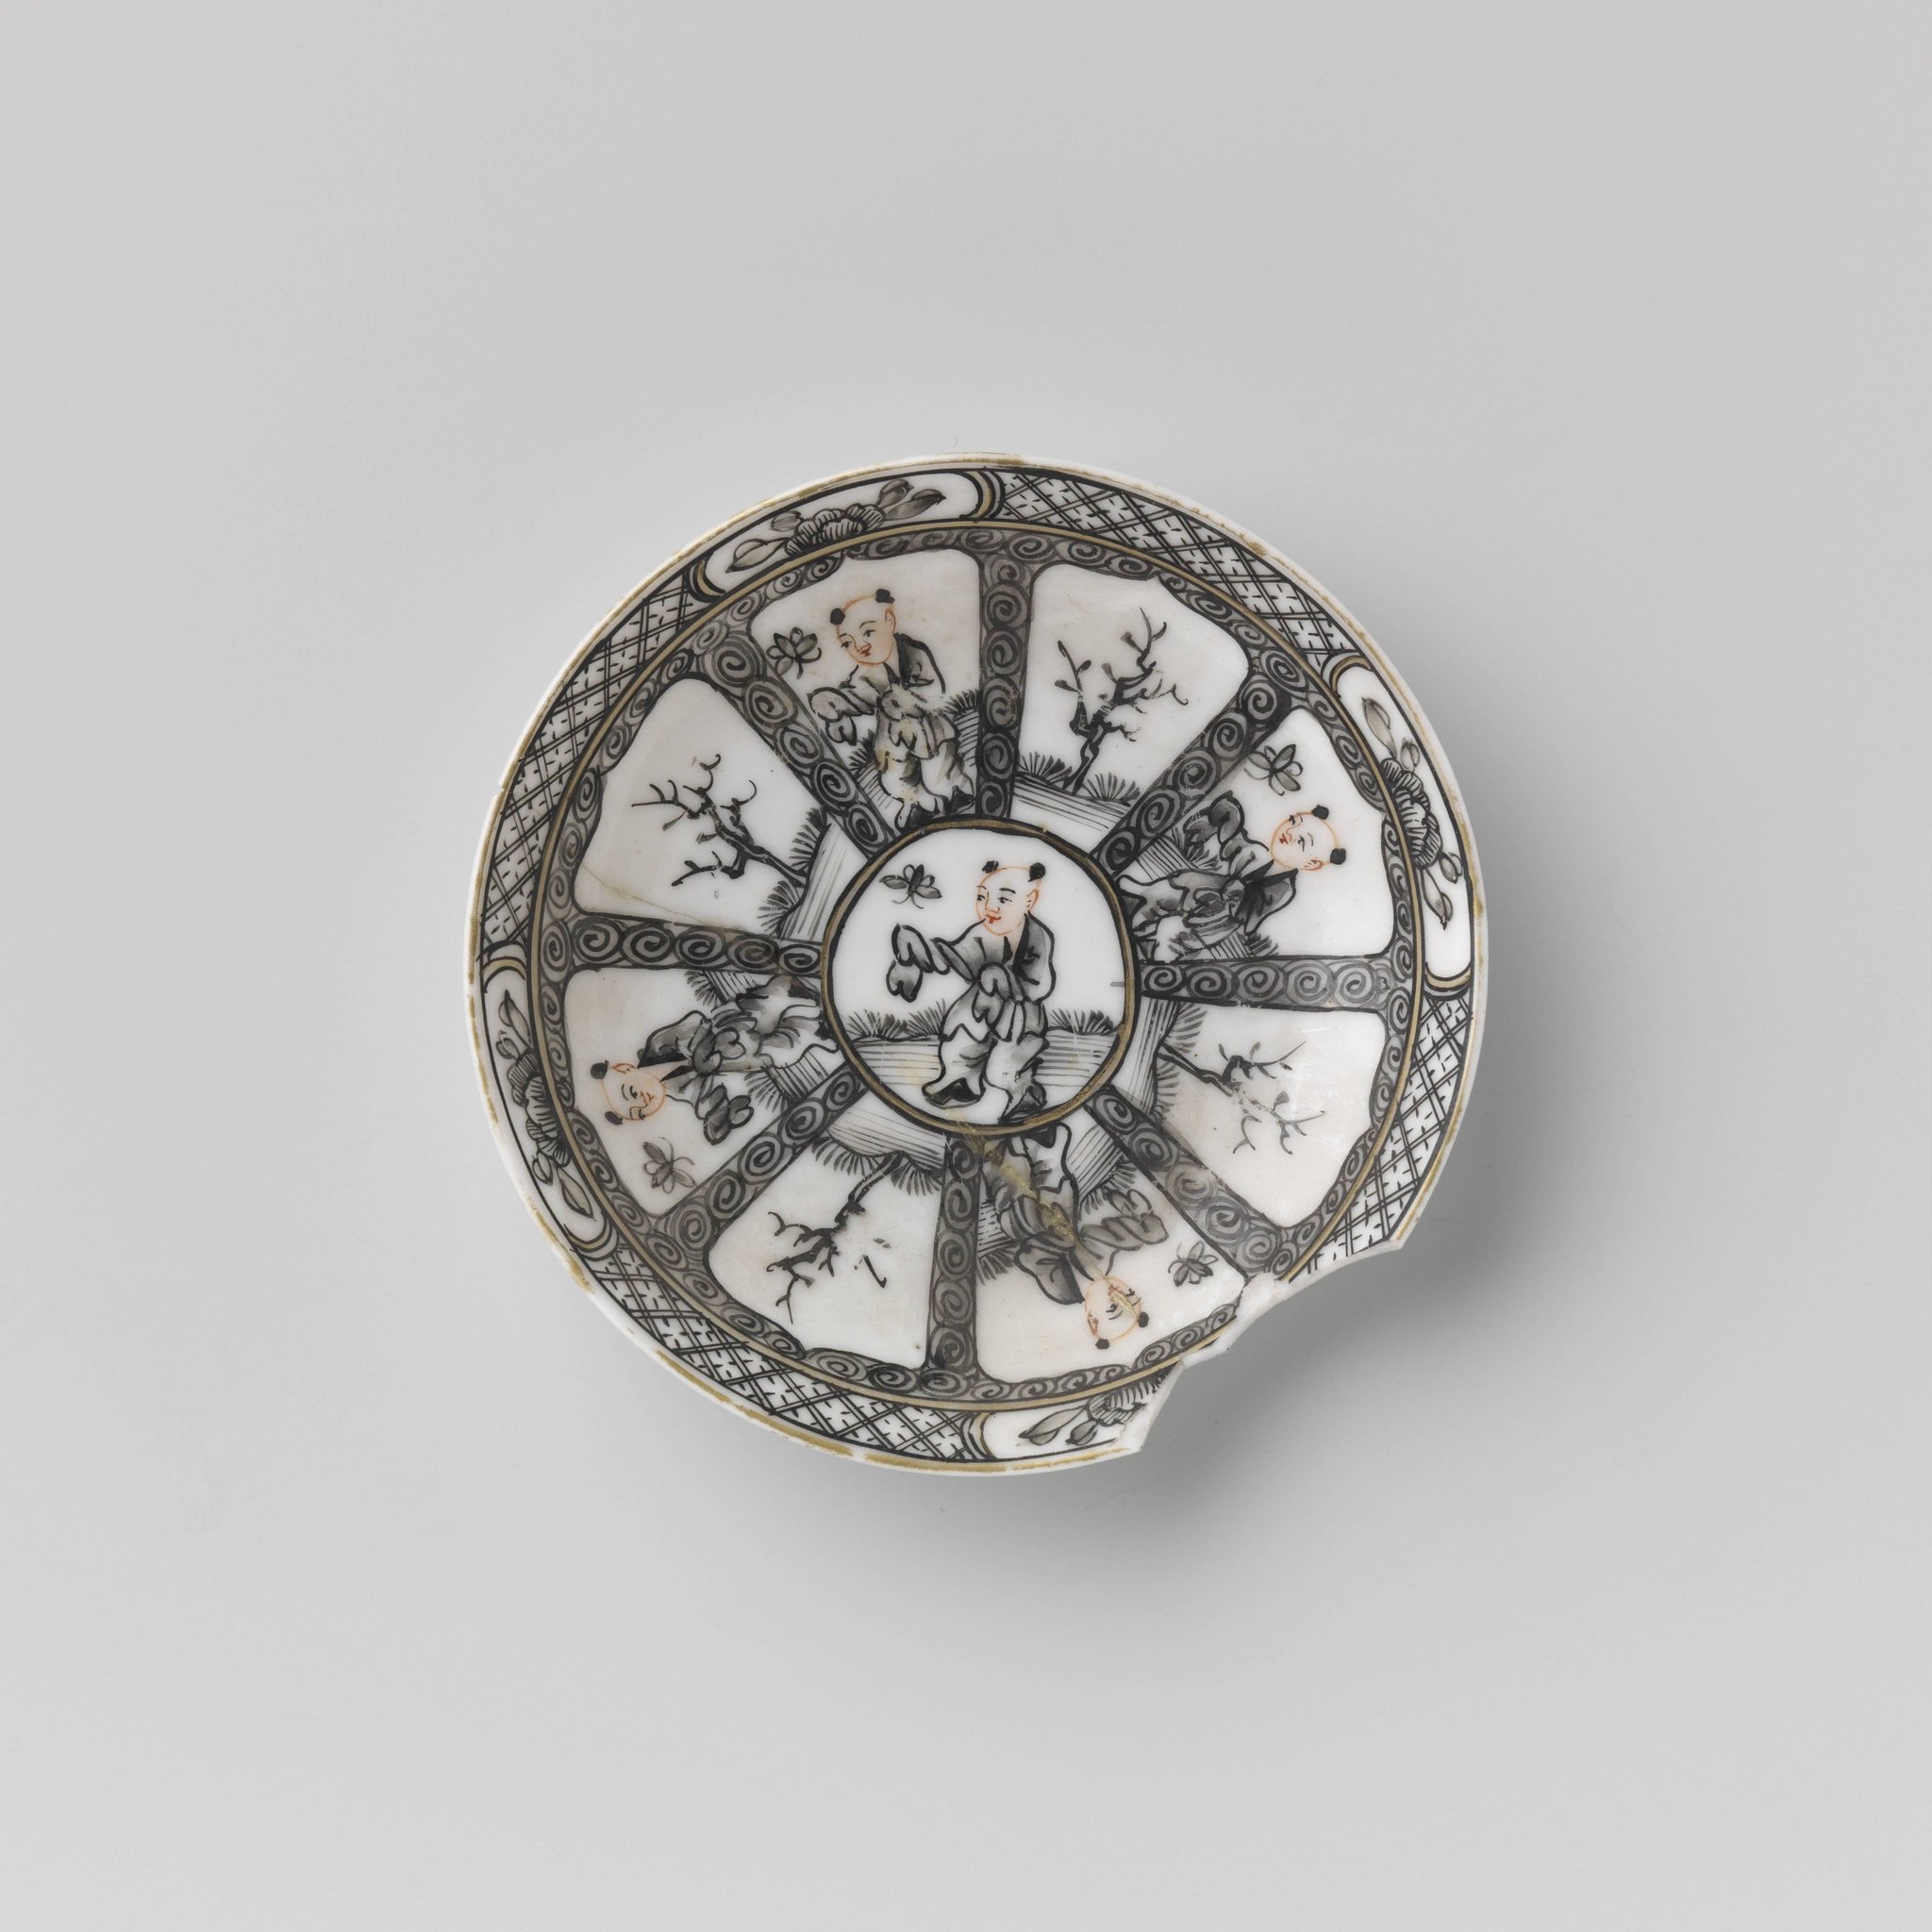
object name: platter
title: Schotel with a boy and a butterfly in a landscape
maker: Anonymous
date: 1725-1749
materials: glaze, gold, paint, porcelain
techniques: firing, gilding, turning, vitrification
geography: china